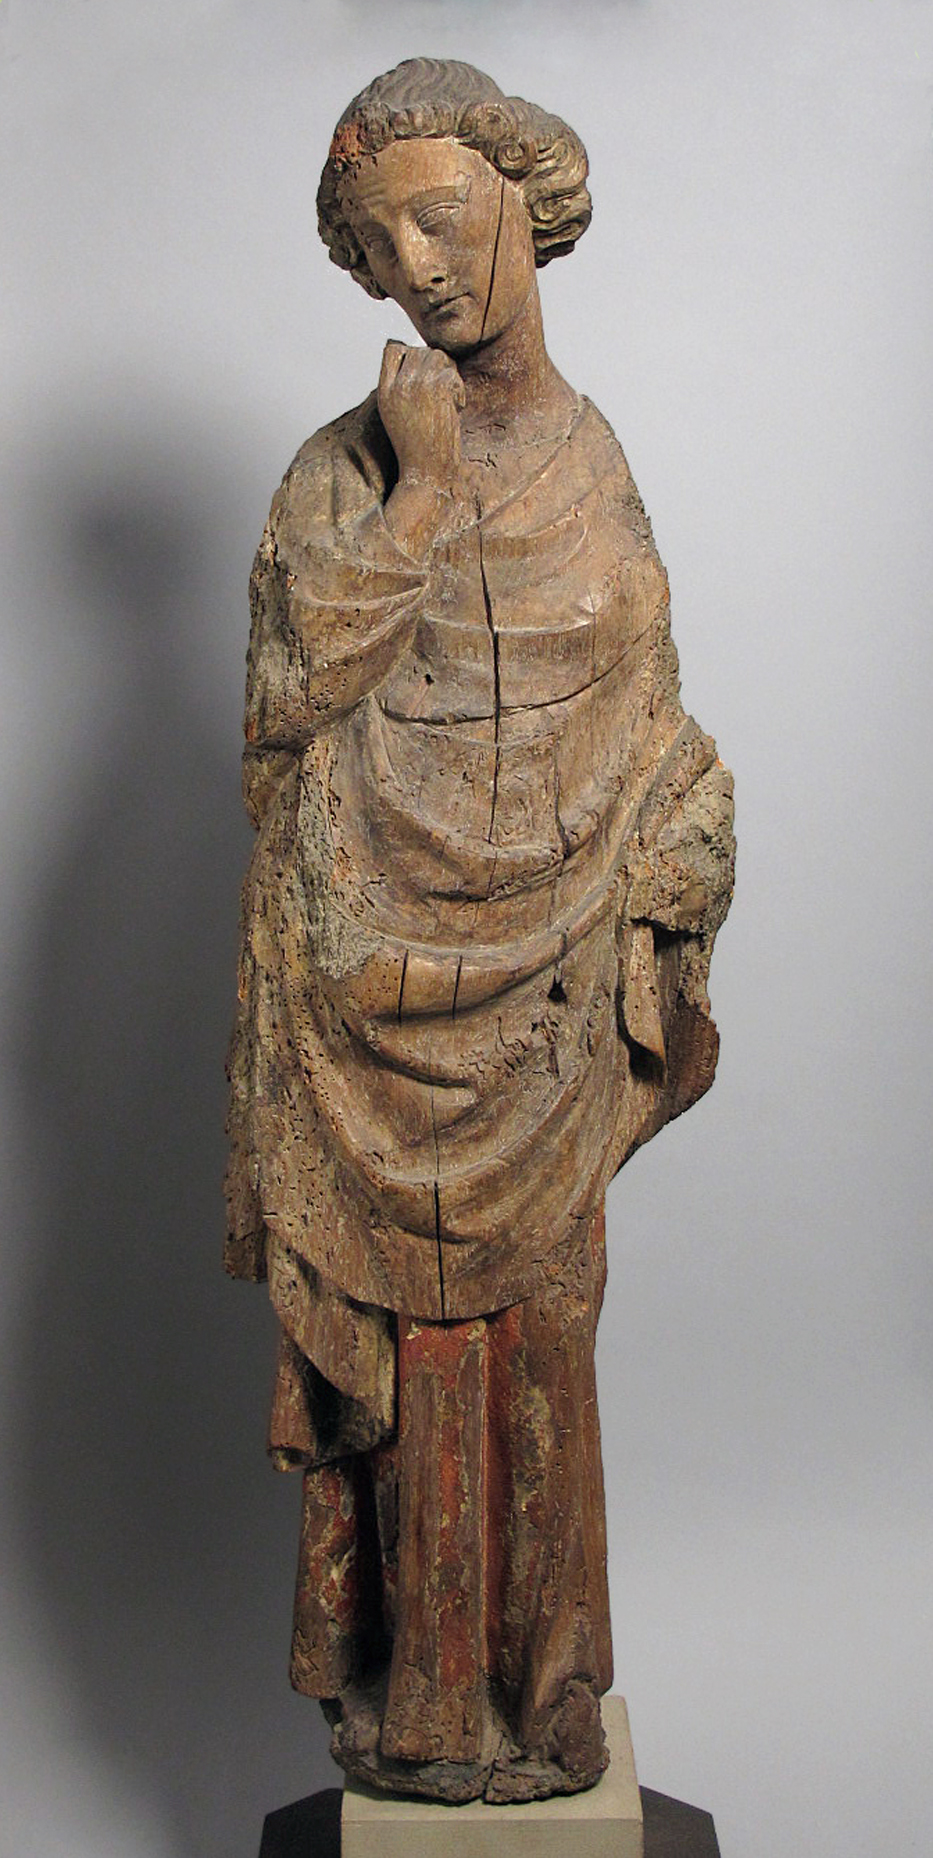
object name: statuette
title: Saint John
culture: french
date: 1301-1400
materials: paint, wood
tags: saint john